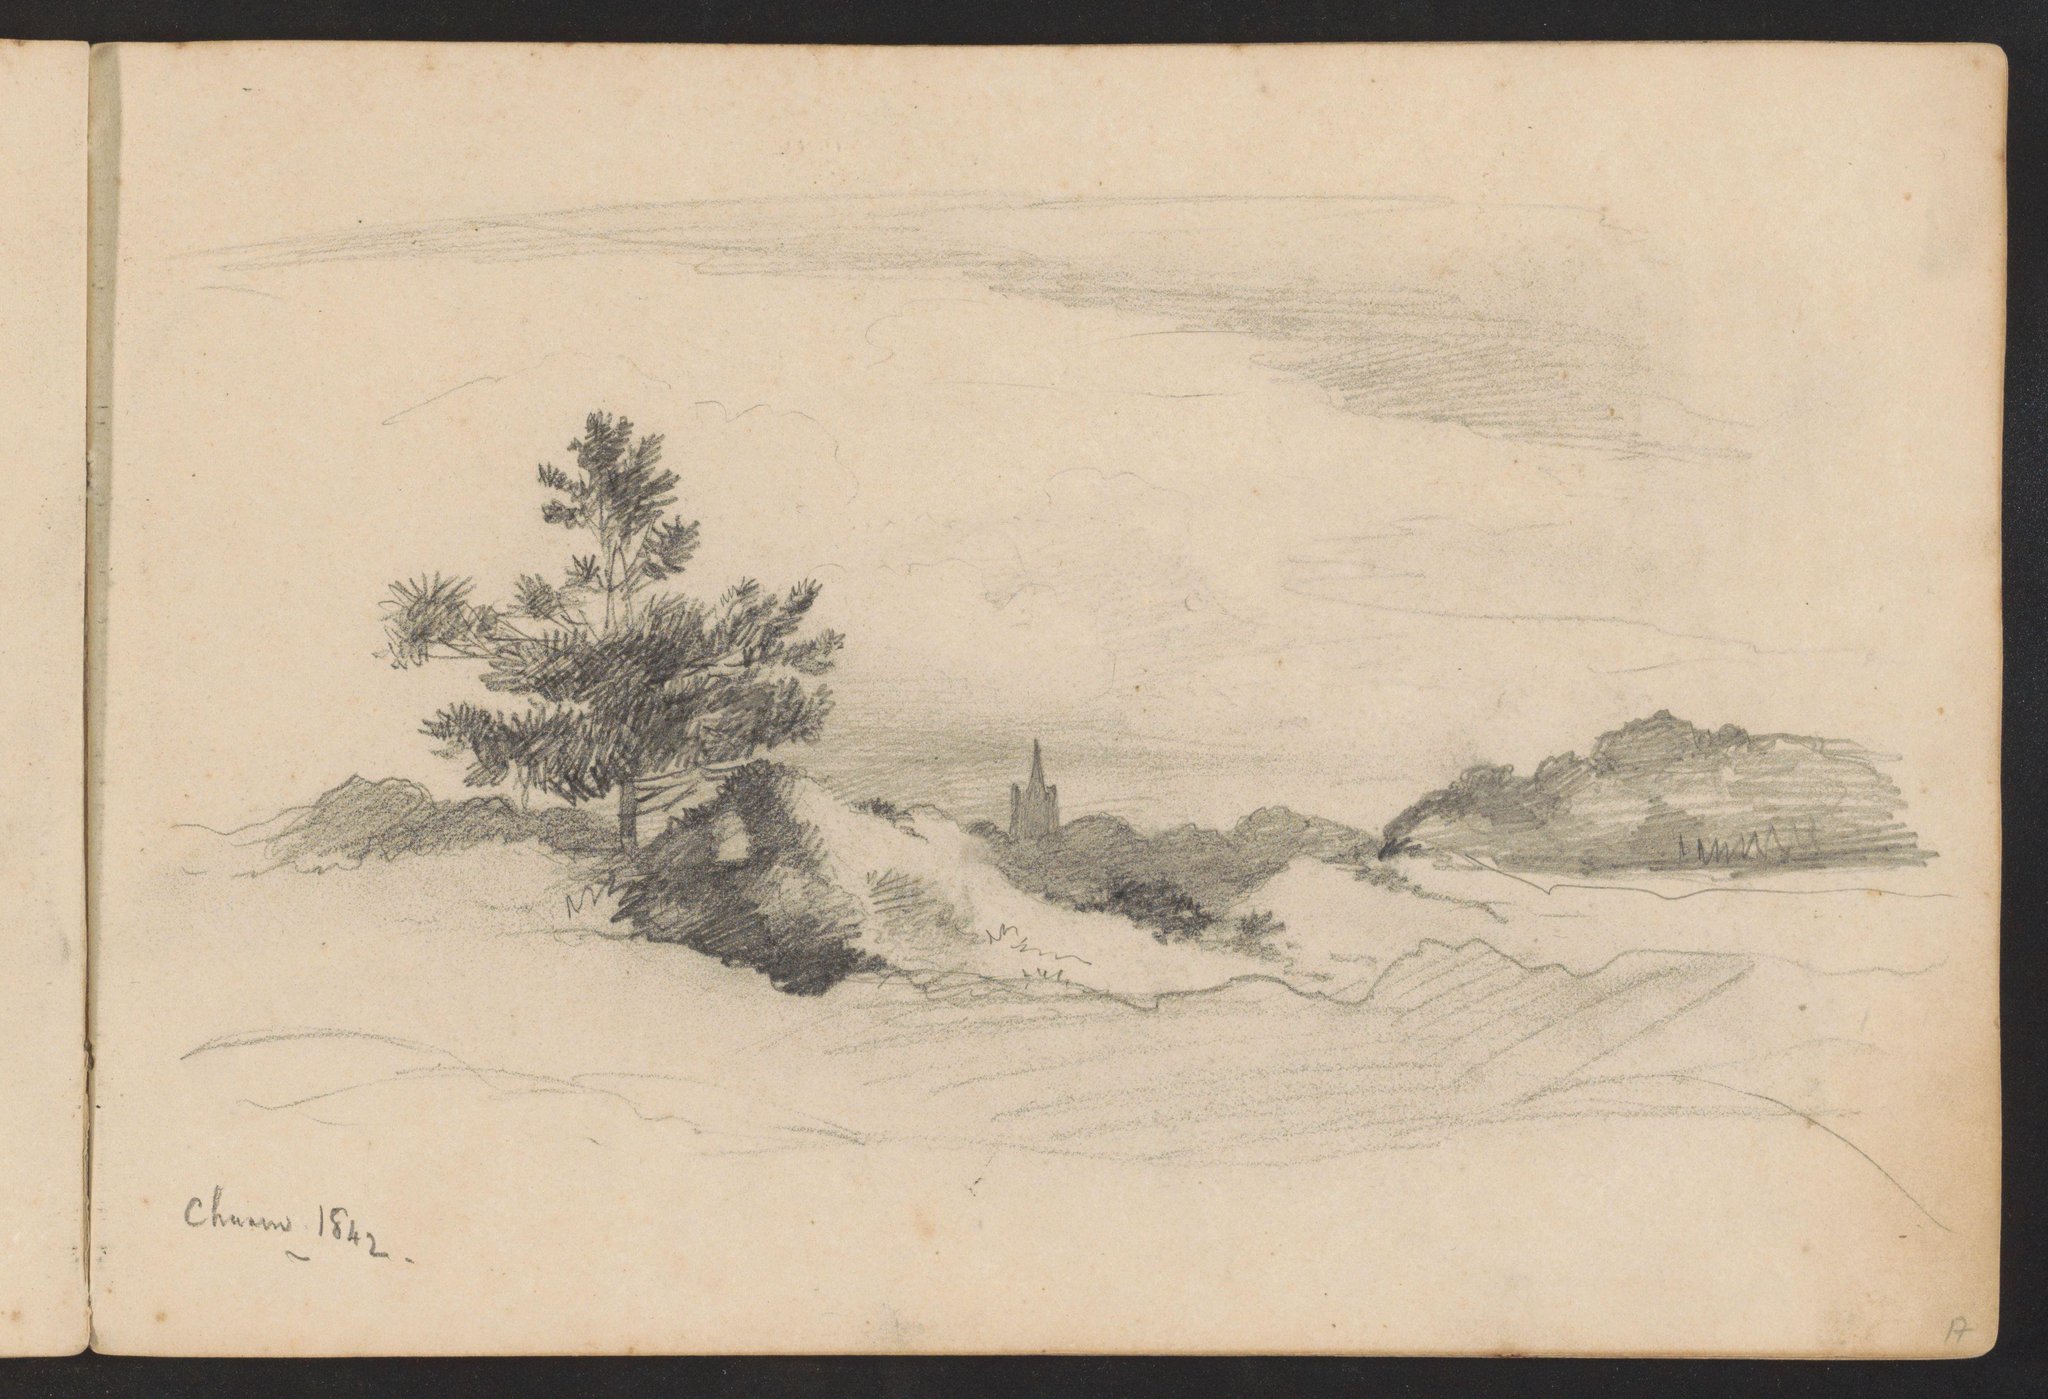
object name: sketchbook leaf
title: Gezicht op Chaam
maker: johannes tavenraat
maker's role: draughtsman, painter, print maker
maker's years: 1809-1881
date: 1842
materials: paper, pencil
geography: chaam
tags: city-view, and landscape with man-made constructions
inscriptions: annotation: ‘Chaam 1842.’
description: Blad 17 recto uit een schetsboek met 45 bladen.